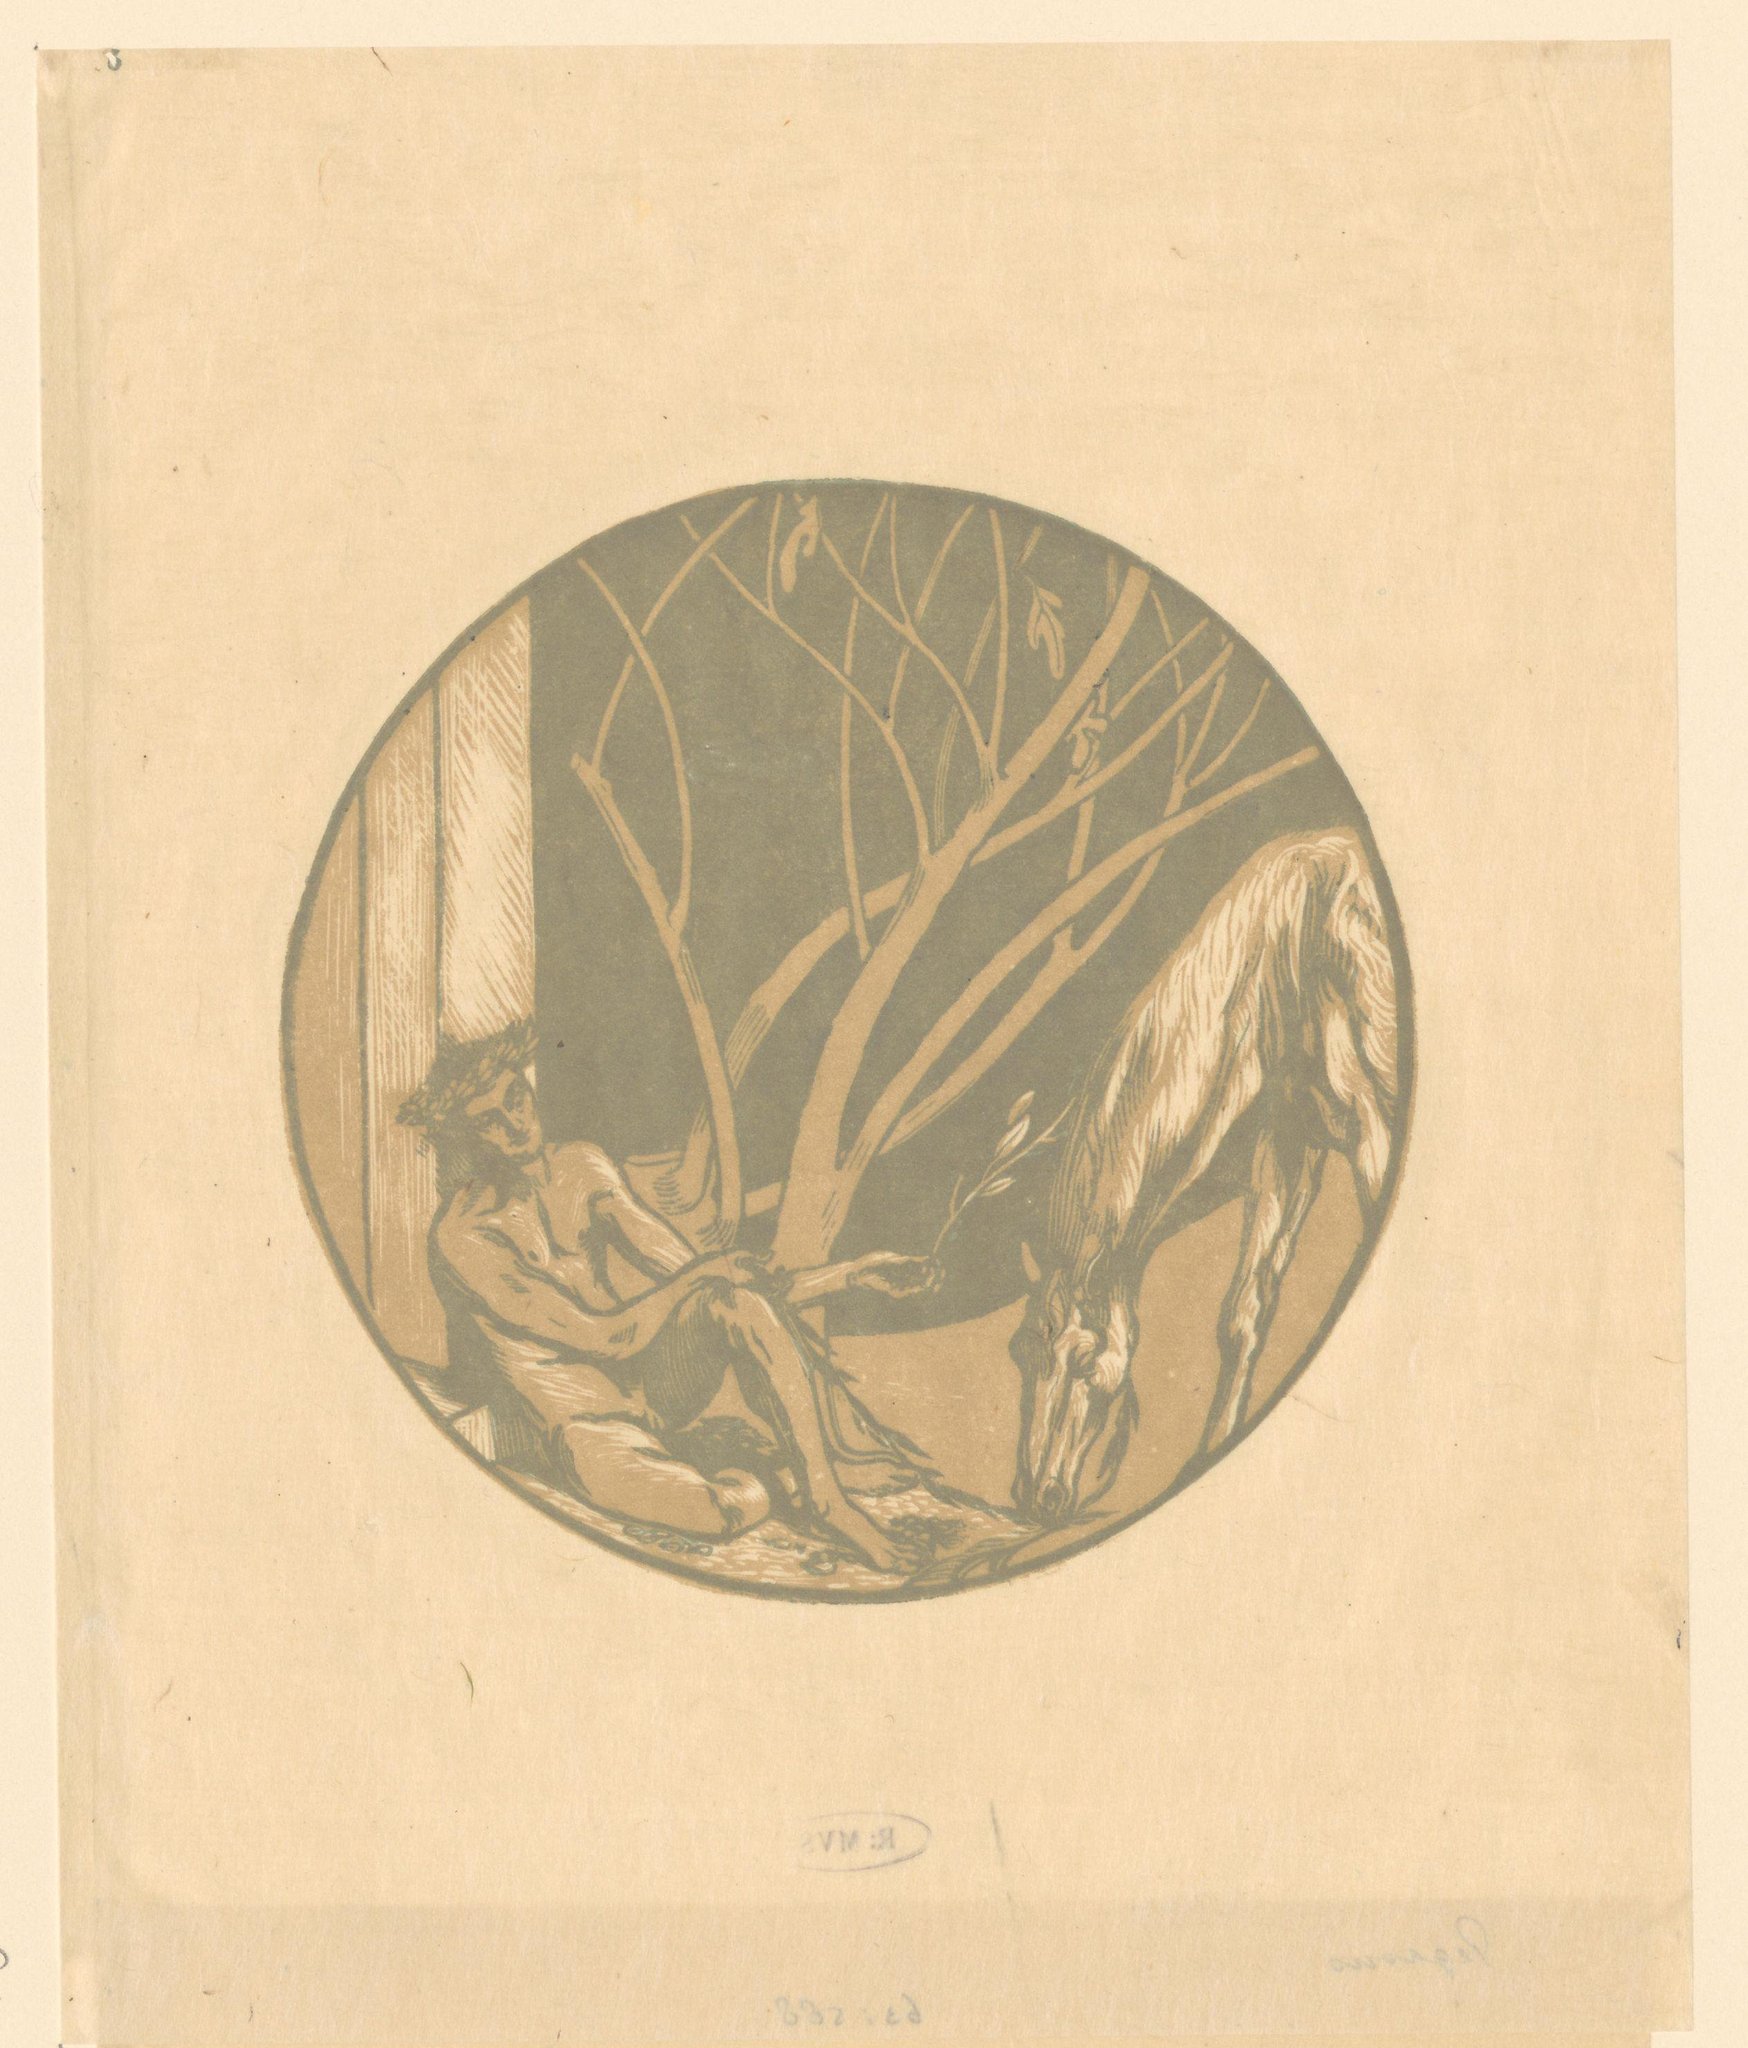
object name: print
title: Man en paard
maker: charles haslewood shannon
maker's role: draughtsman, print maker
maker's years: 1865-1937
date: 1898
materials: paper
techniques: woodcut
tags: horse, sitting on the ground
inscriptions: collector's mark: Lugt 2228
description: Prent maakt waarschijnlijk deel uit van een serie met twaalf voorstellingen. Over deze serie is verder niets bekend. Het betreft voornamelijk voorstellingen met betrekking tot de twaalf maanden van het jaar en oogsten.